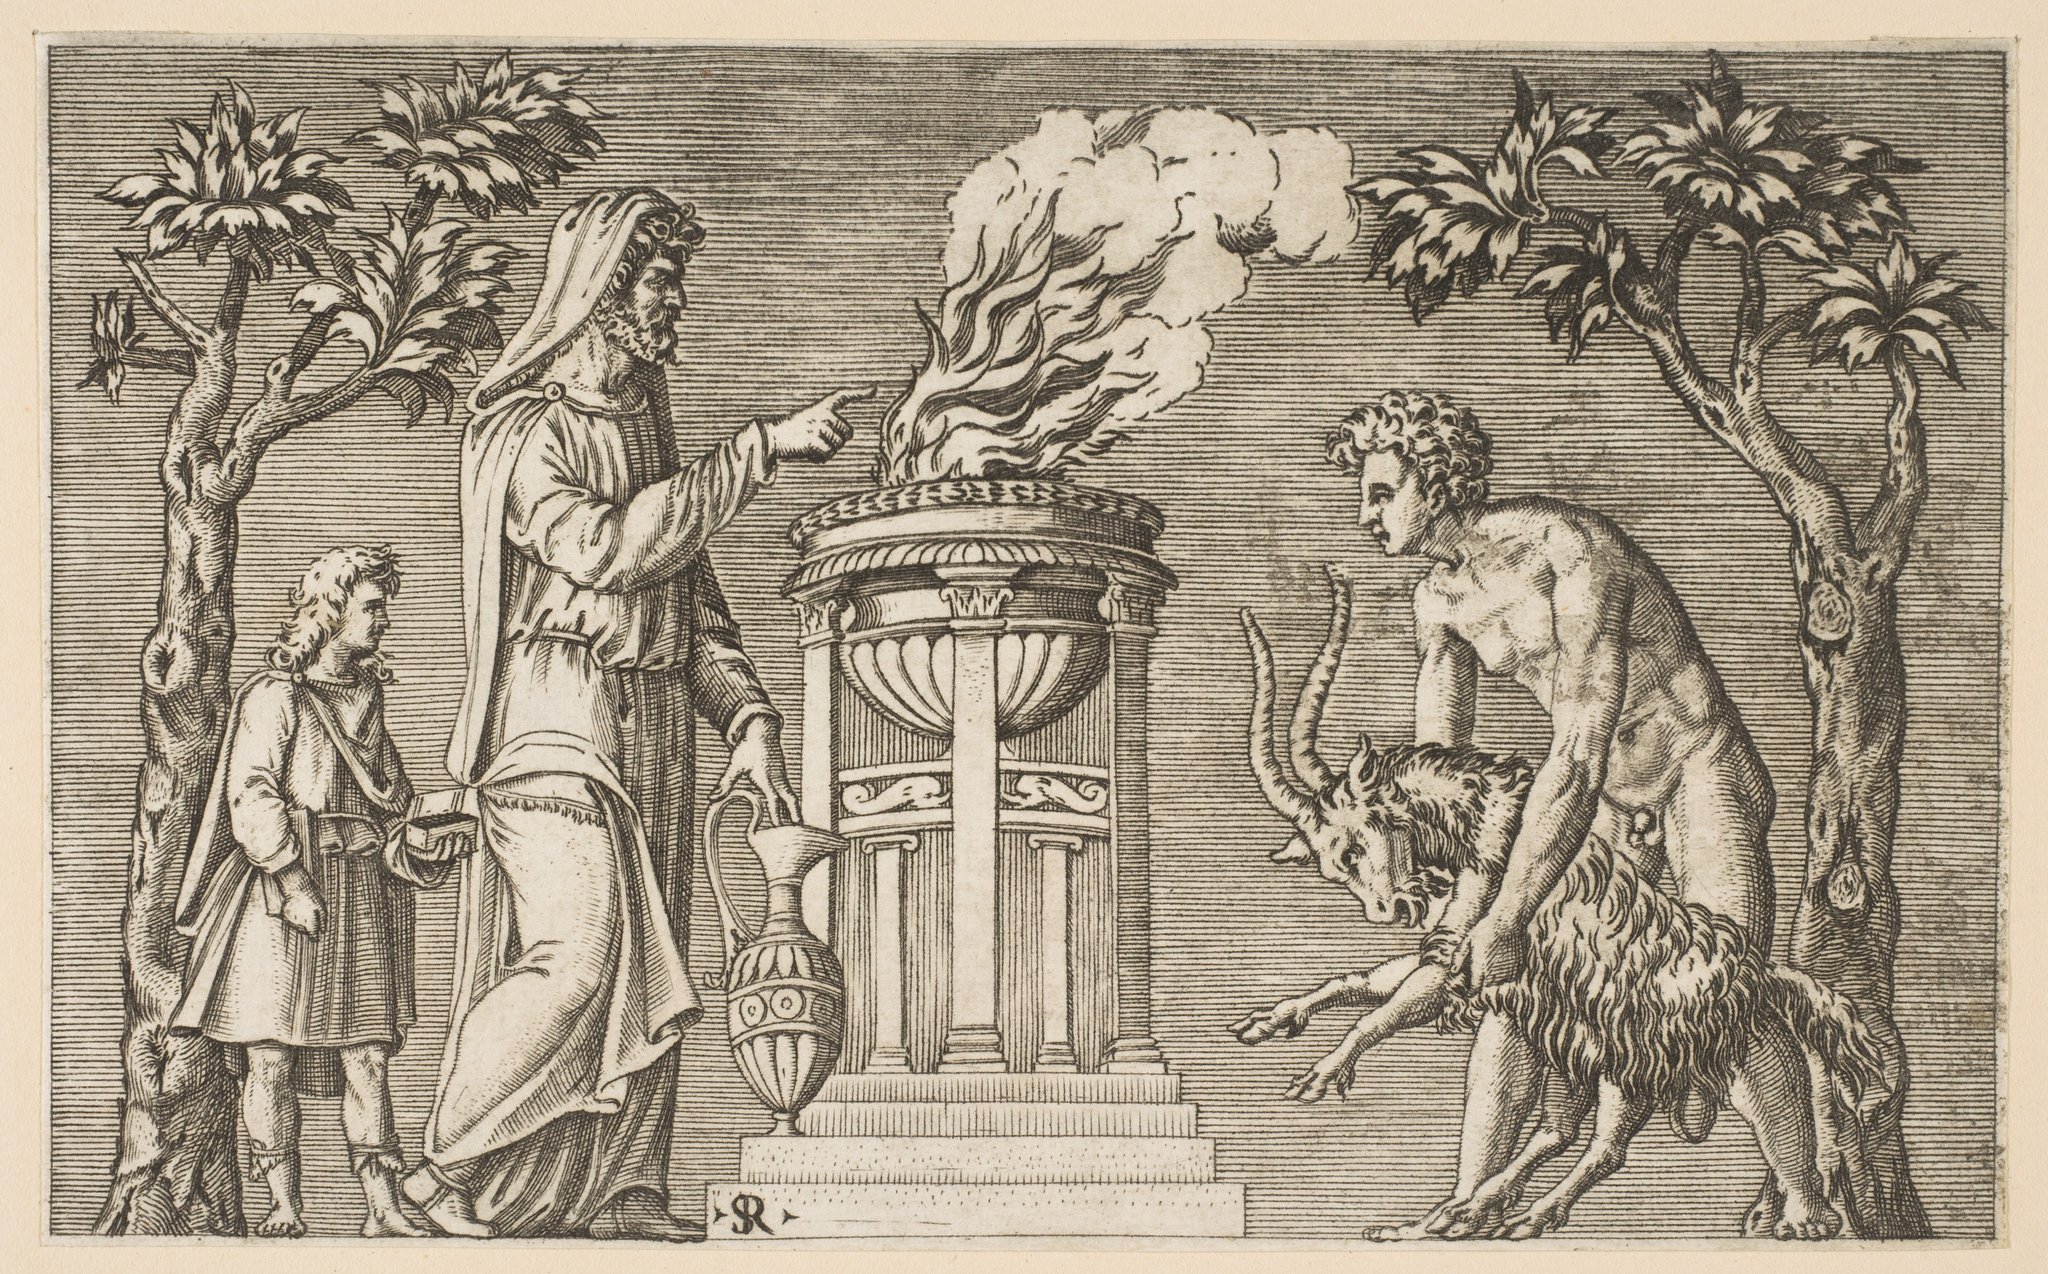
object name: print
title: The Sacrifice of a Ram; naked man at right guiding a ram towards an altar pyre, hooded priest at left with a young attendant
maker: marco dente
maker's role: artist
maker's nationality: italian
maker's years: 1515-1527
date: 1515-1527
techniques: engraving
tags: men,male nudes,rams,trees